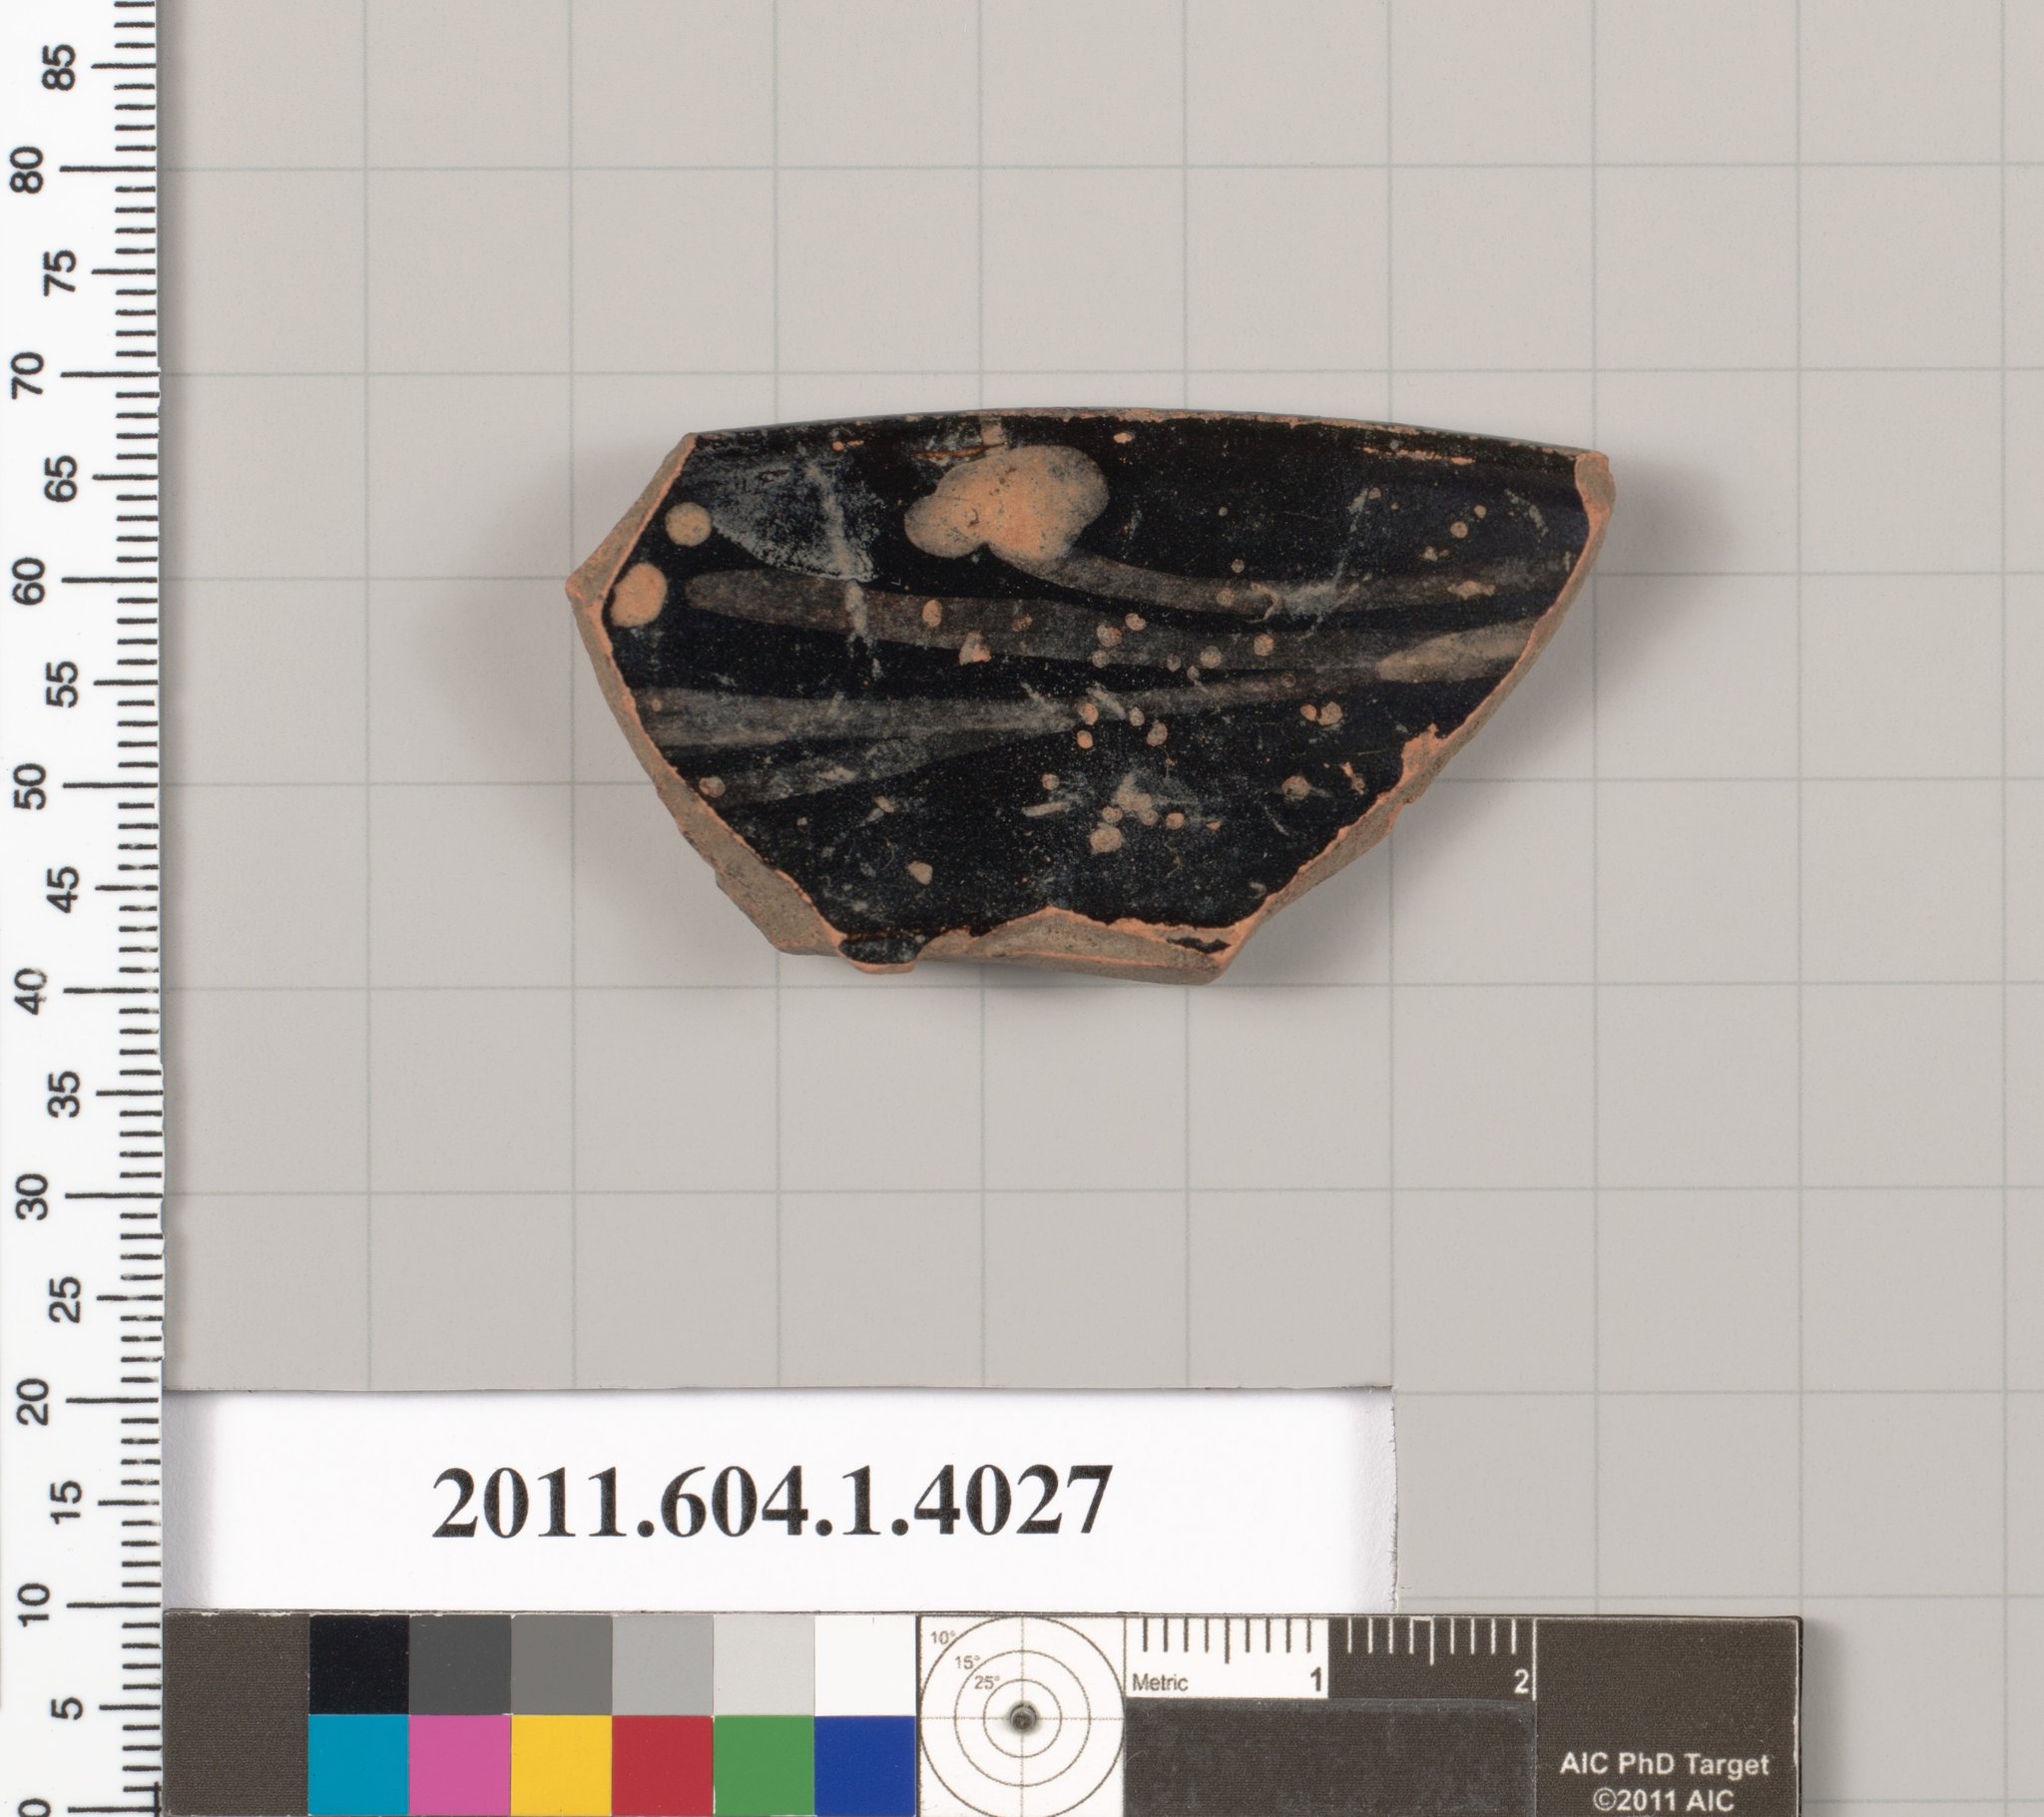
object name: kylix fragment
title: Terracotta rim fragment of a kylix (drinking cup)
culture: greek, attic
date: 460-440 BCE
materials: terracotta